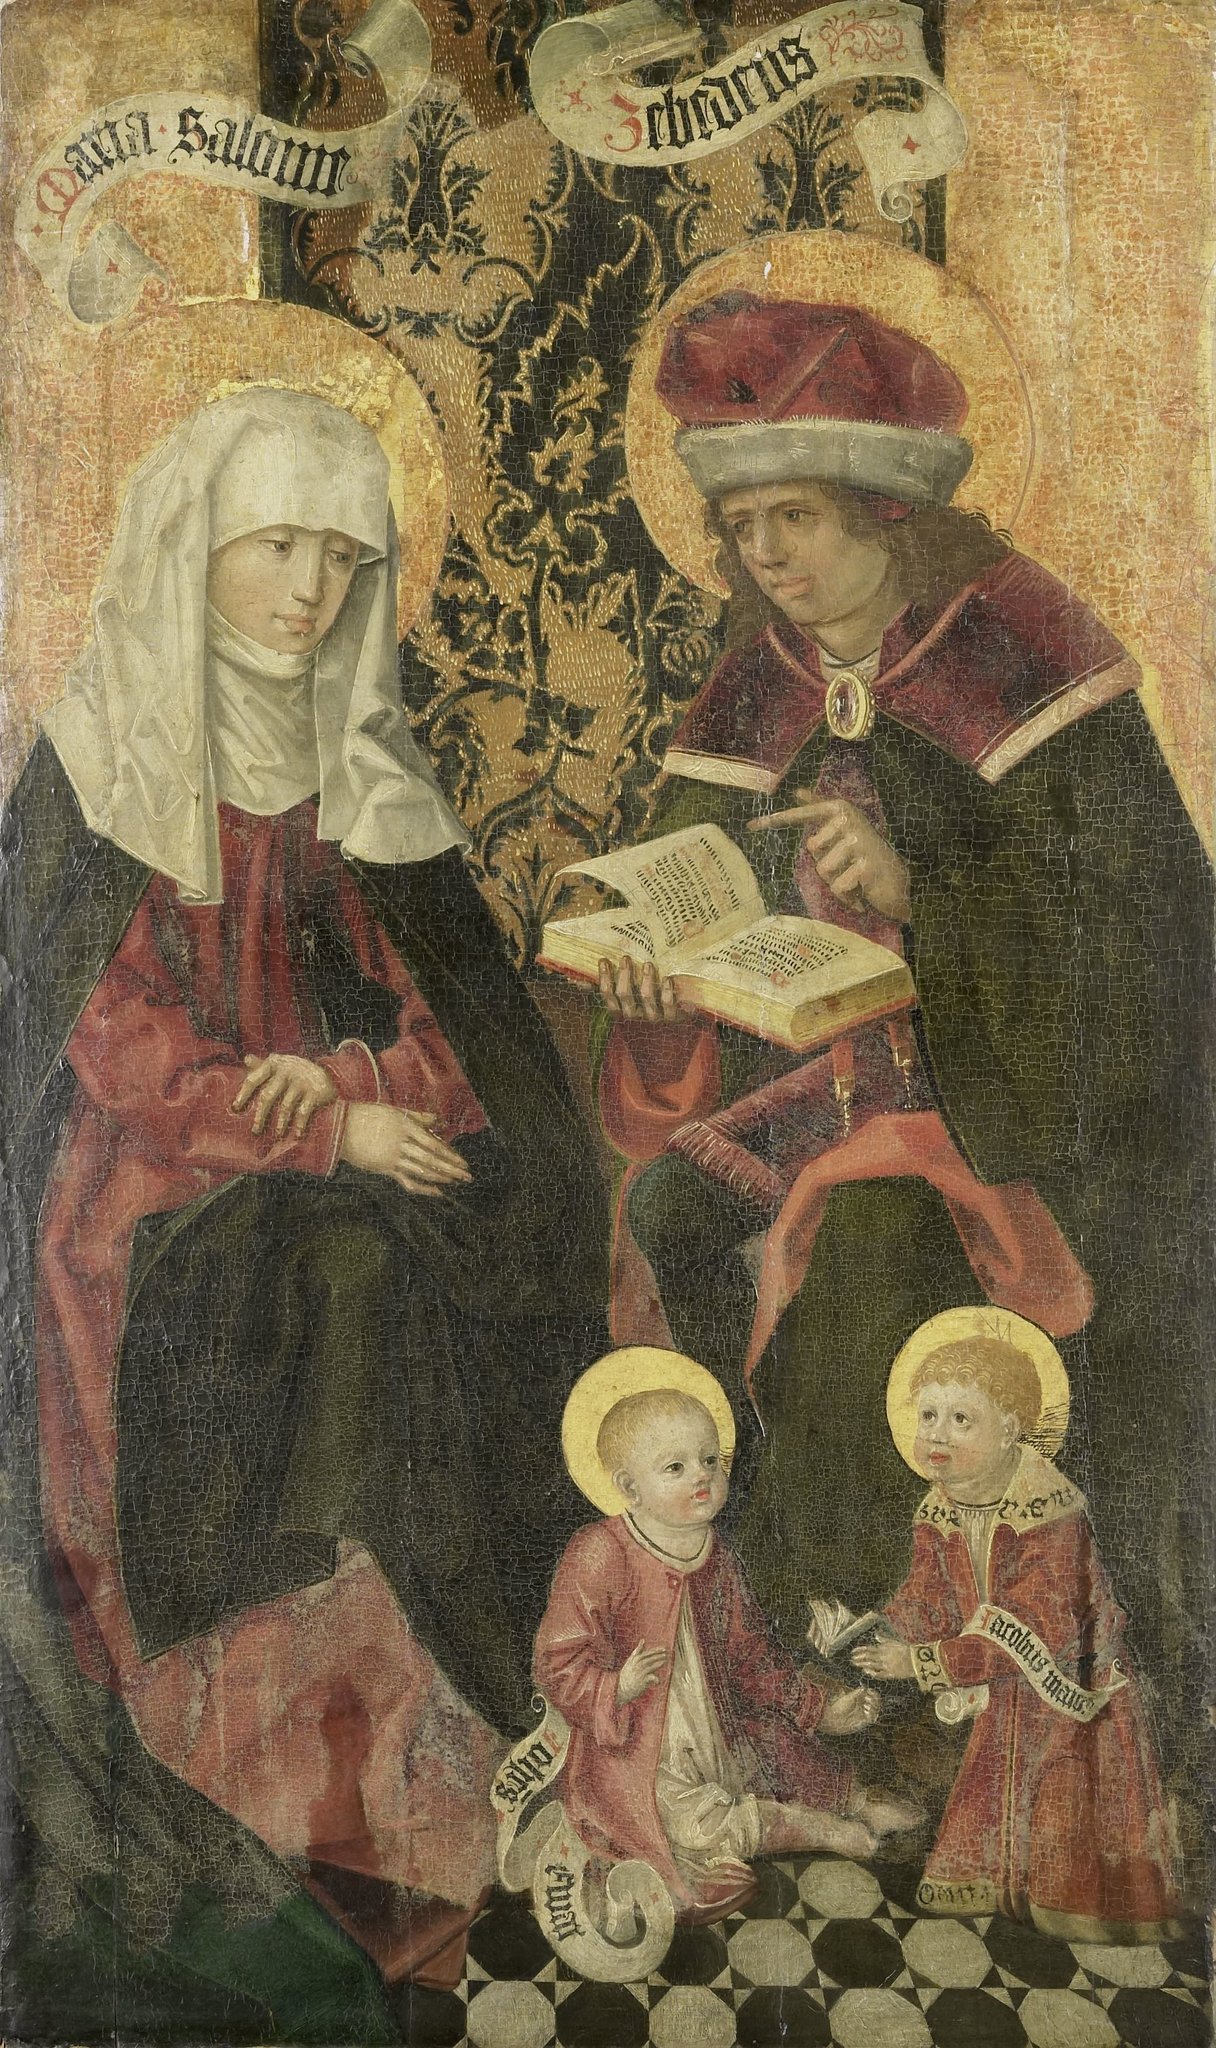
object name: painting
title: The Family of Zebedee / Angel Gabriel from an Annunciation (remnants on the verso)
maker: Anonymous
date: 1490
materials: canvas, oil, panel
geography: lower rhine region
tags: the apostle john the evangelist; possible attributes: book, cauldron, chalice with snake, eagle, palm, scroll, mary salome, sister of the virgin and mother of james the great and john the evangelist, also one of the midwives; possible attributes: jar of ointment, the apostle james the great; possible attributes: book, pilgrim's cloak, hat, shell, staff, and wallet, scroll, sword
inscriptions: inscription: ‘Maria Salome / Zebedeus / Joh[ann]is evan. / Jacobus maior’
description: Het gezin van Zebedeus. Zebedeus zittend wijzend op een opengeslagen boek op schoot, links zit Maria Salome. Op de vloer spelen hun kinderen Johannes (de Evangelist) en Jacobus Major. Op de achterzijde restanten van een voorstelling van Maria of de engel uit een verkondiging aan Maria? Onderaan ook enkele kleine figuurtjes. De linkervleugel van een drieluik.